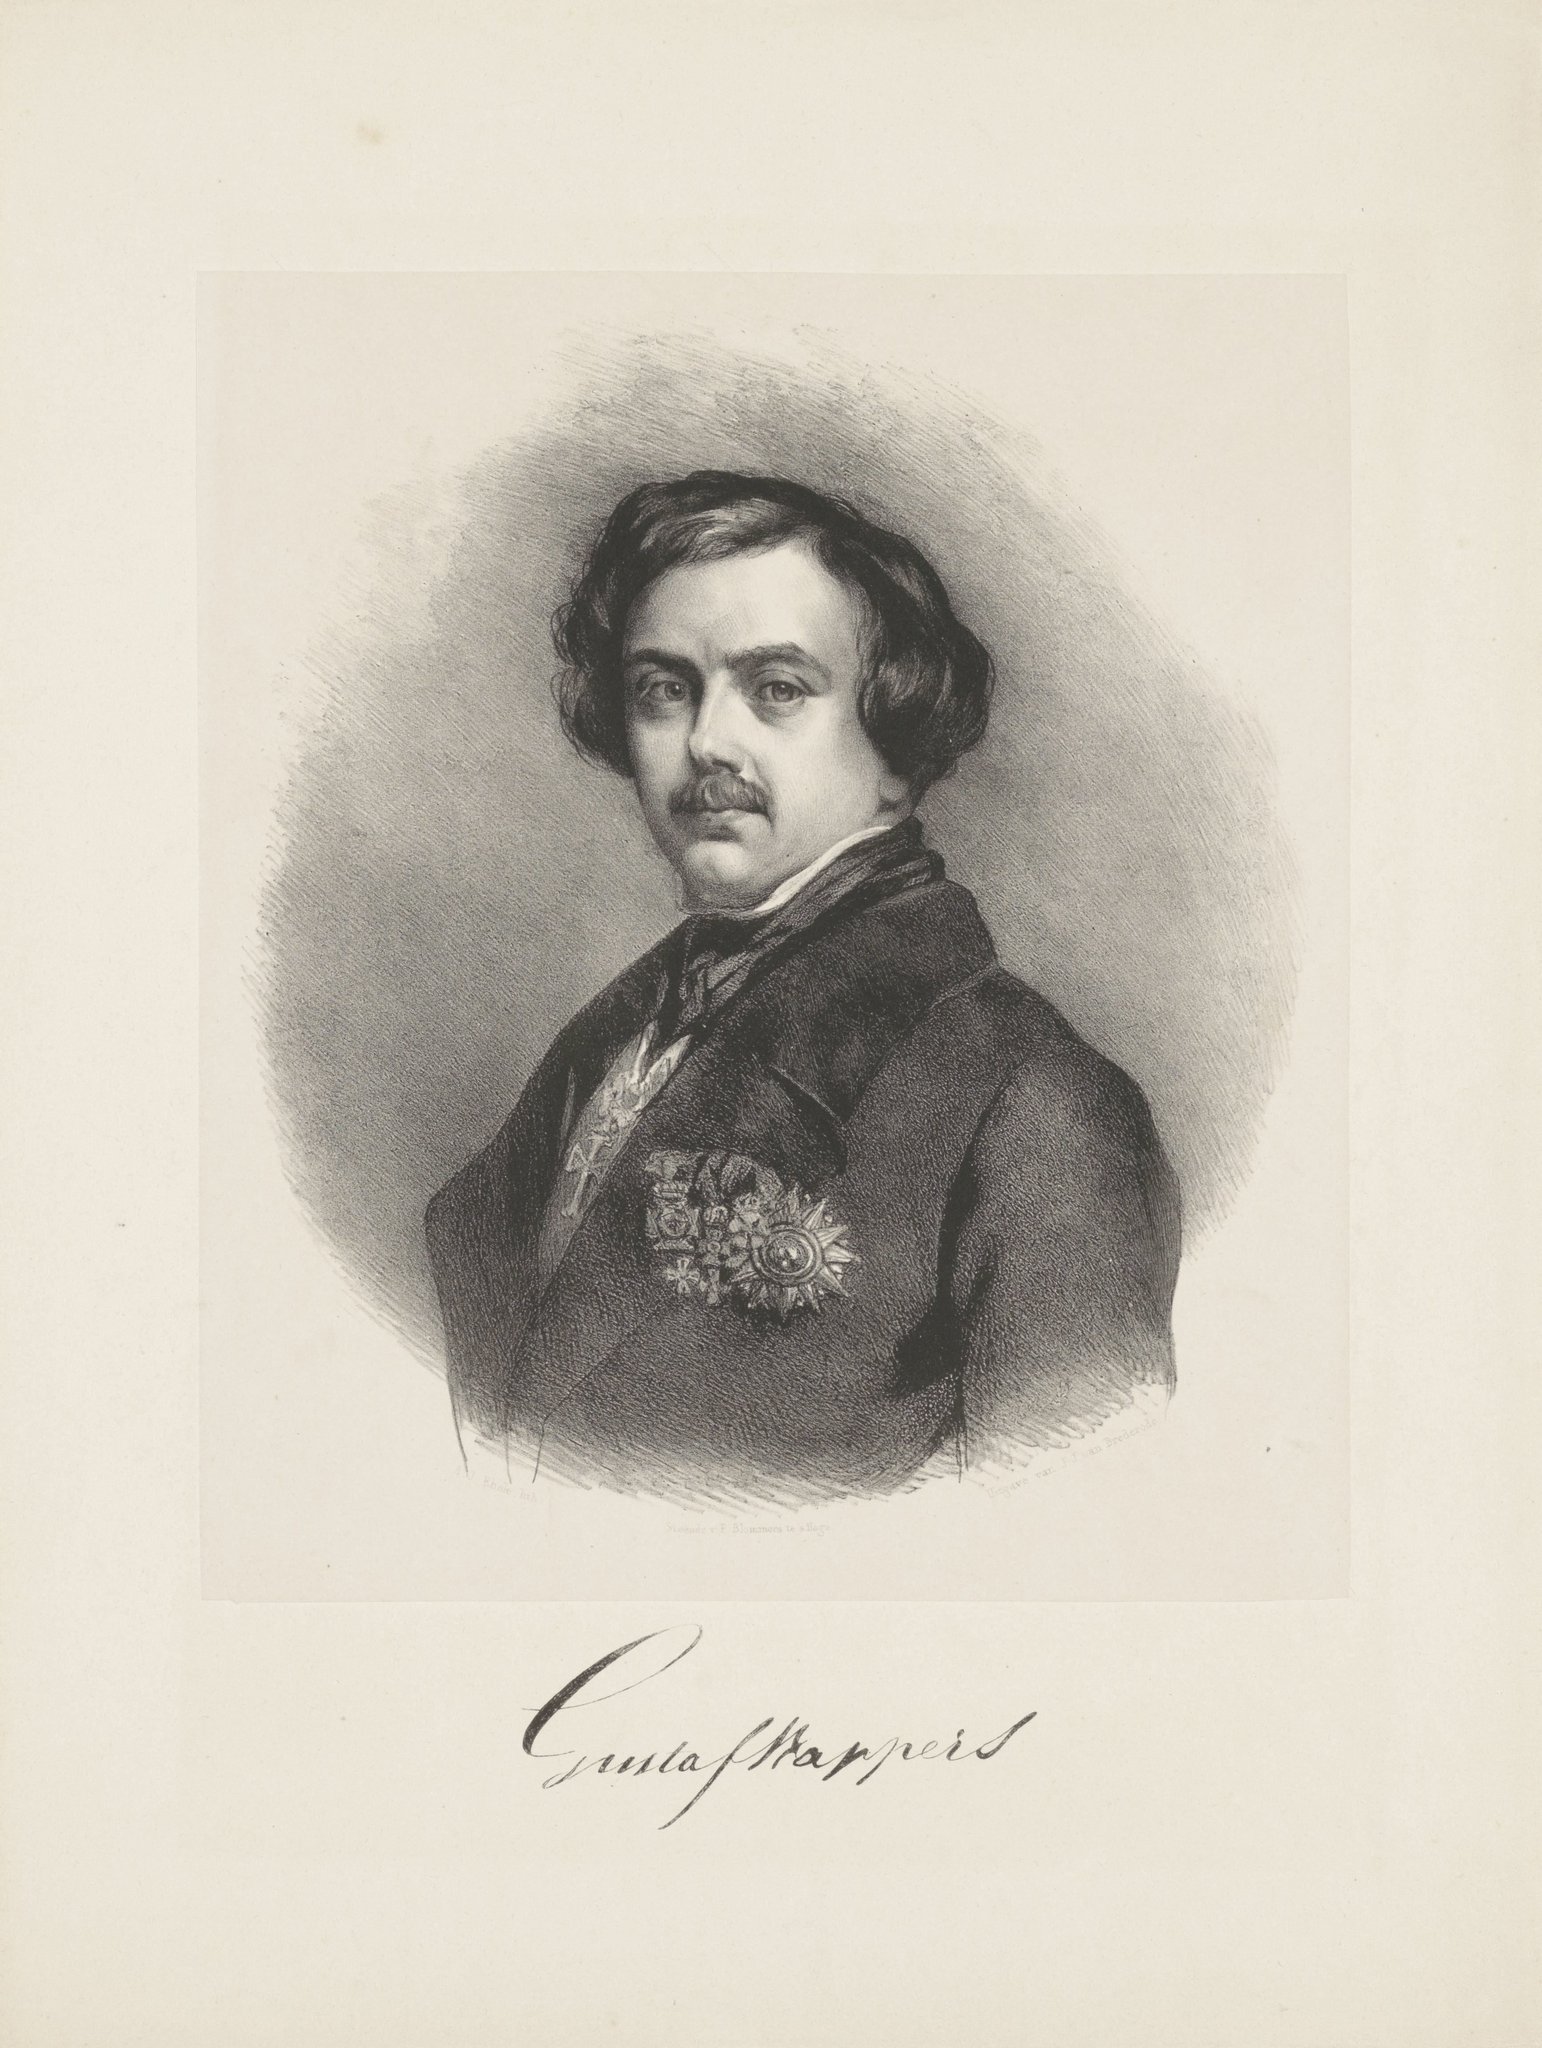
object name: print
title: Portret van Gustave Wappers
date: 1847-1853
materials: paper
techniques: lithograph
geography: the hague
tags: antwerp, paris, painter, print maker, draughtsman, gustave wappers, knighthood order, historical persons (+ (full) bust portrait)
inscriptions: collector's mark: Lugt 2228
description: De geportretteerde draagt een aantal ridderorden op zijn borst en om zijn hals.